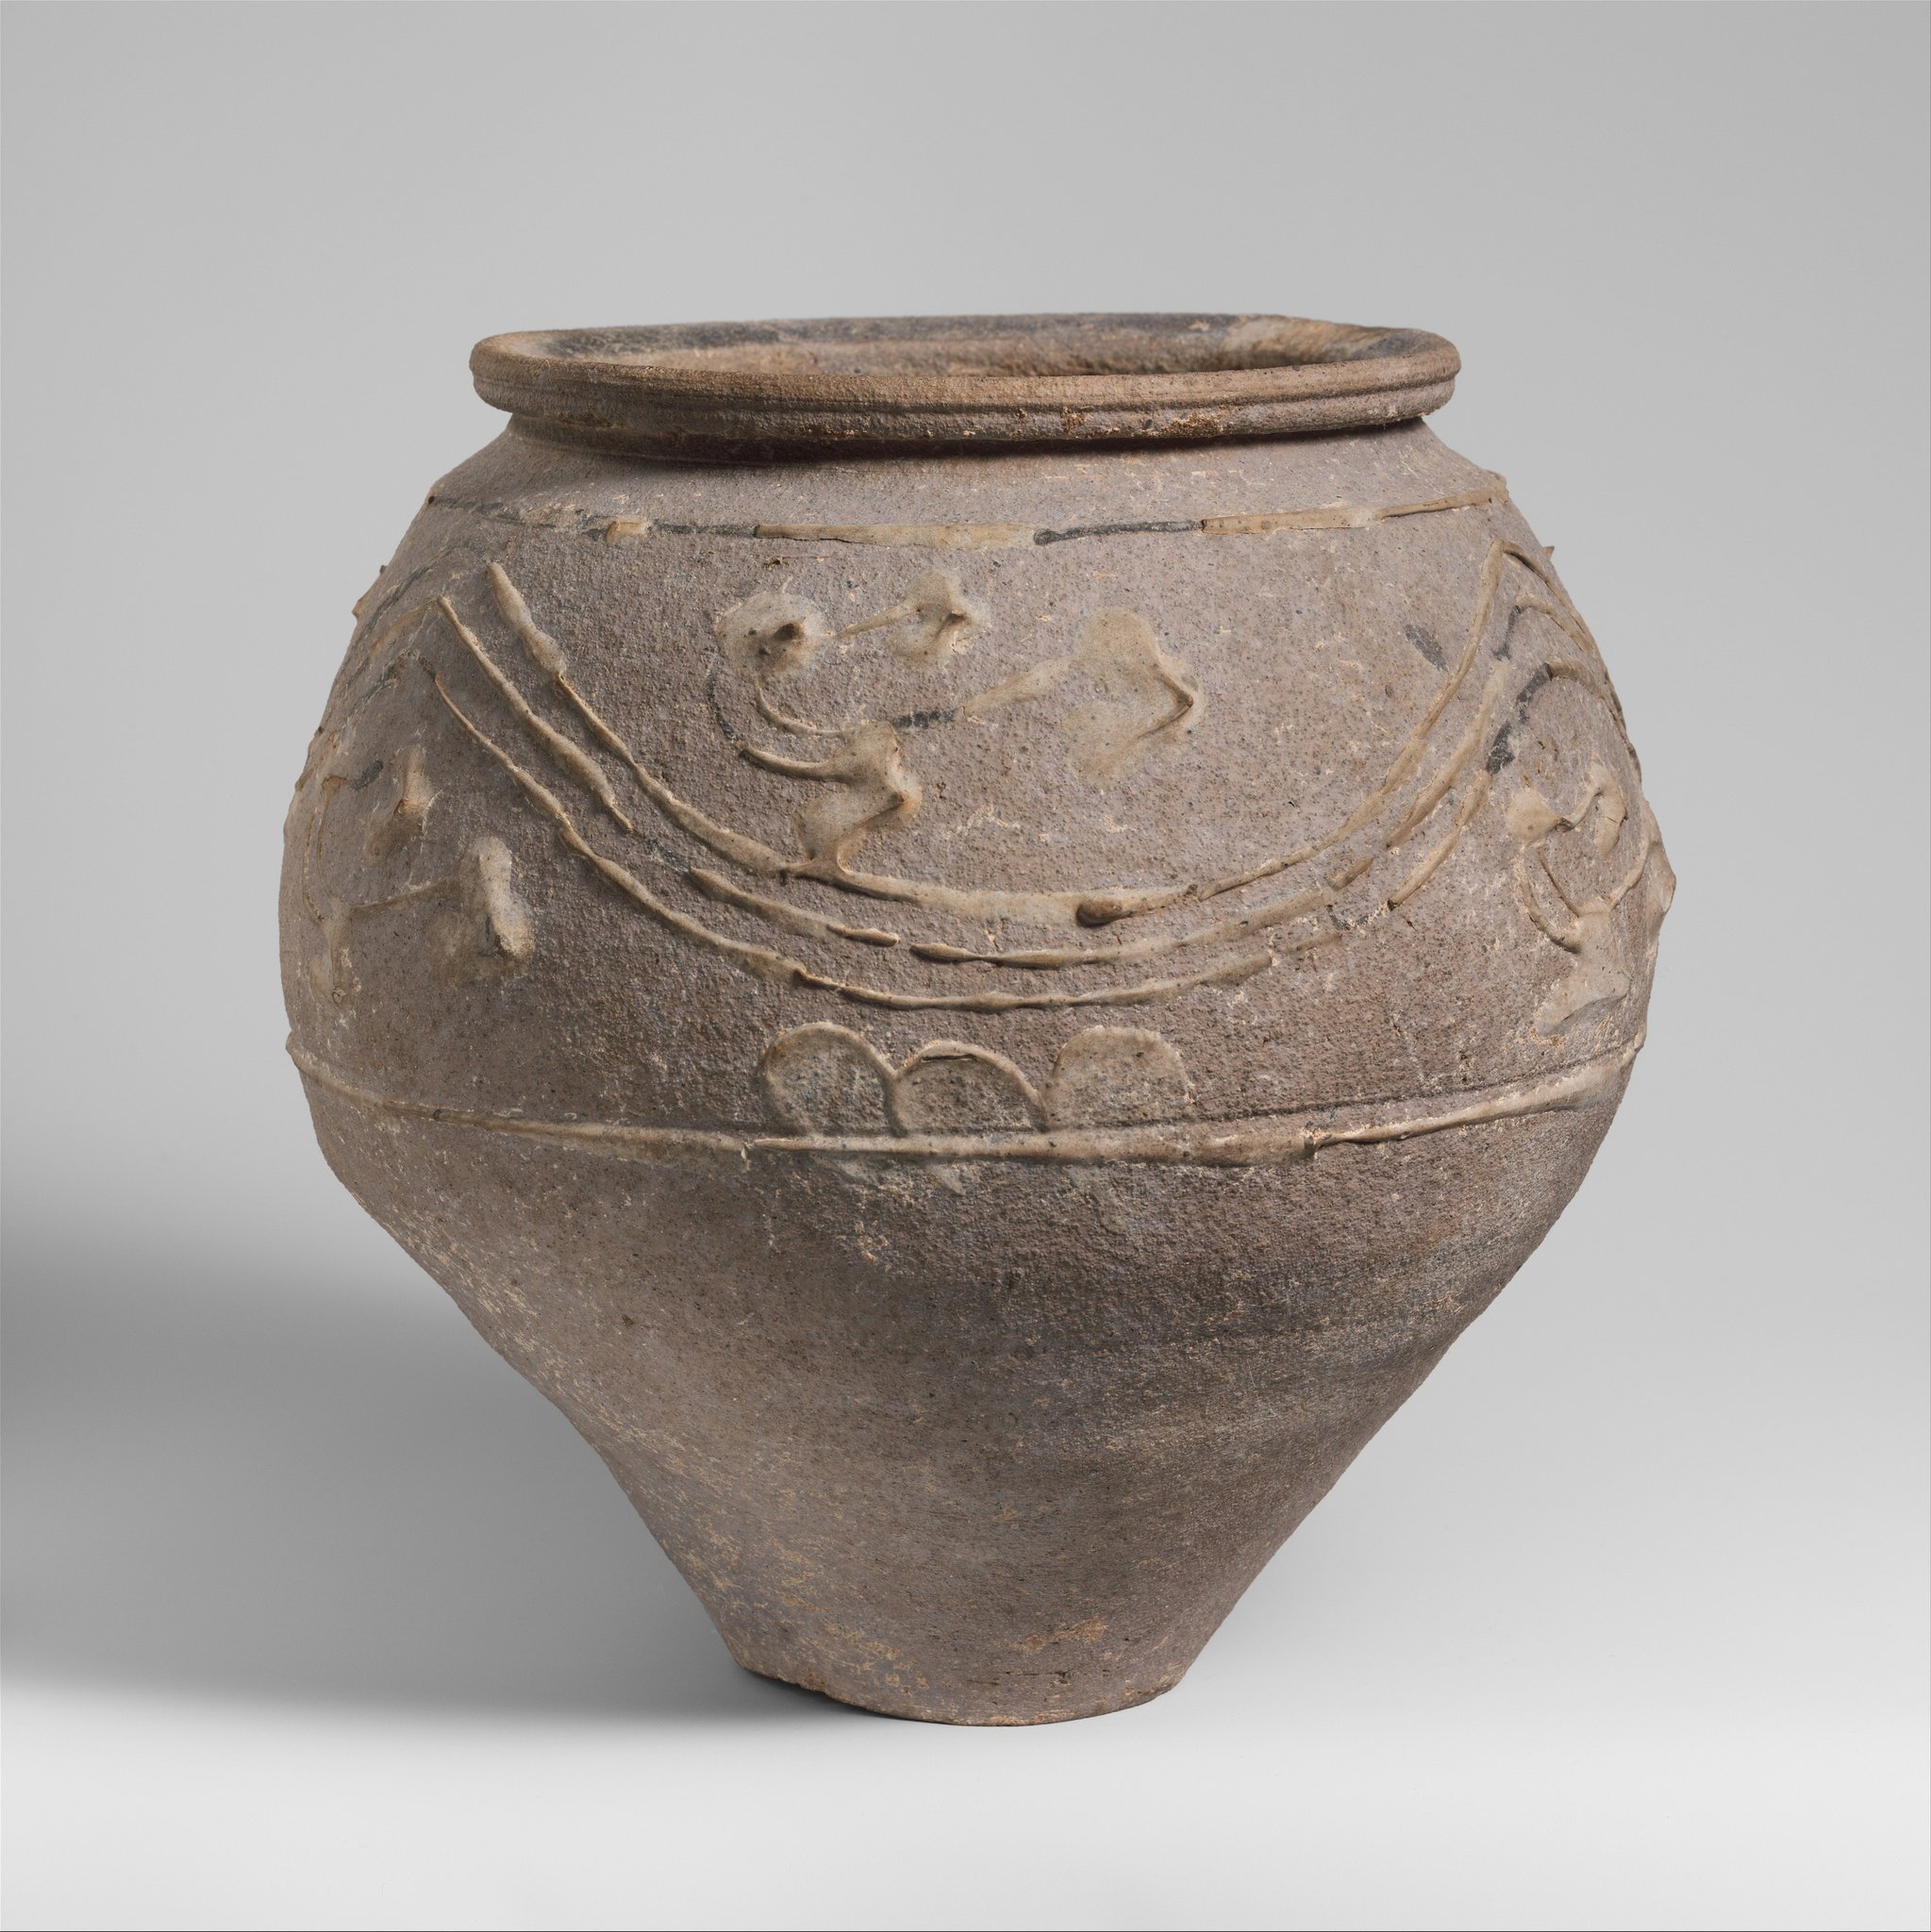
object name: urn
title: Terracotta jar with barbotine decoration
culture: roman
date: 101-300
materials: terracotta